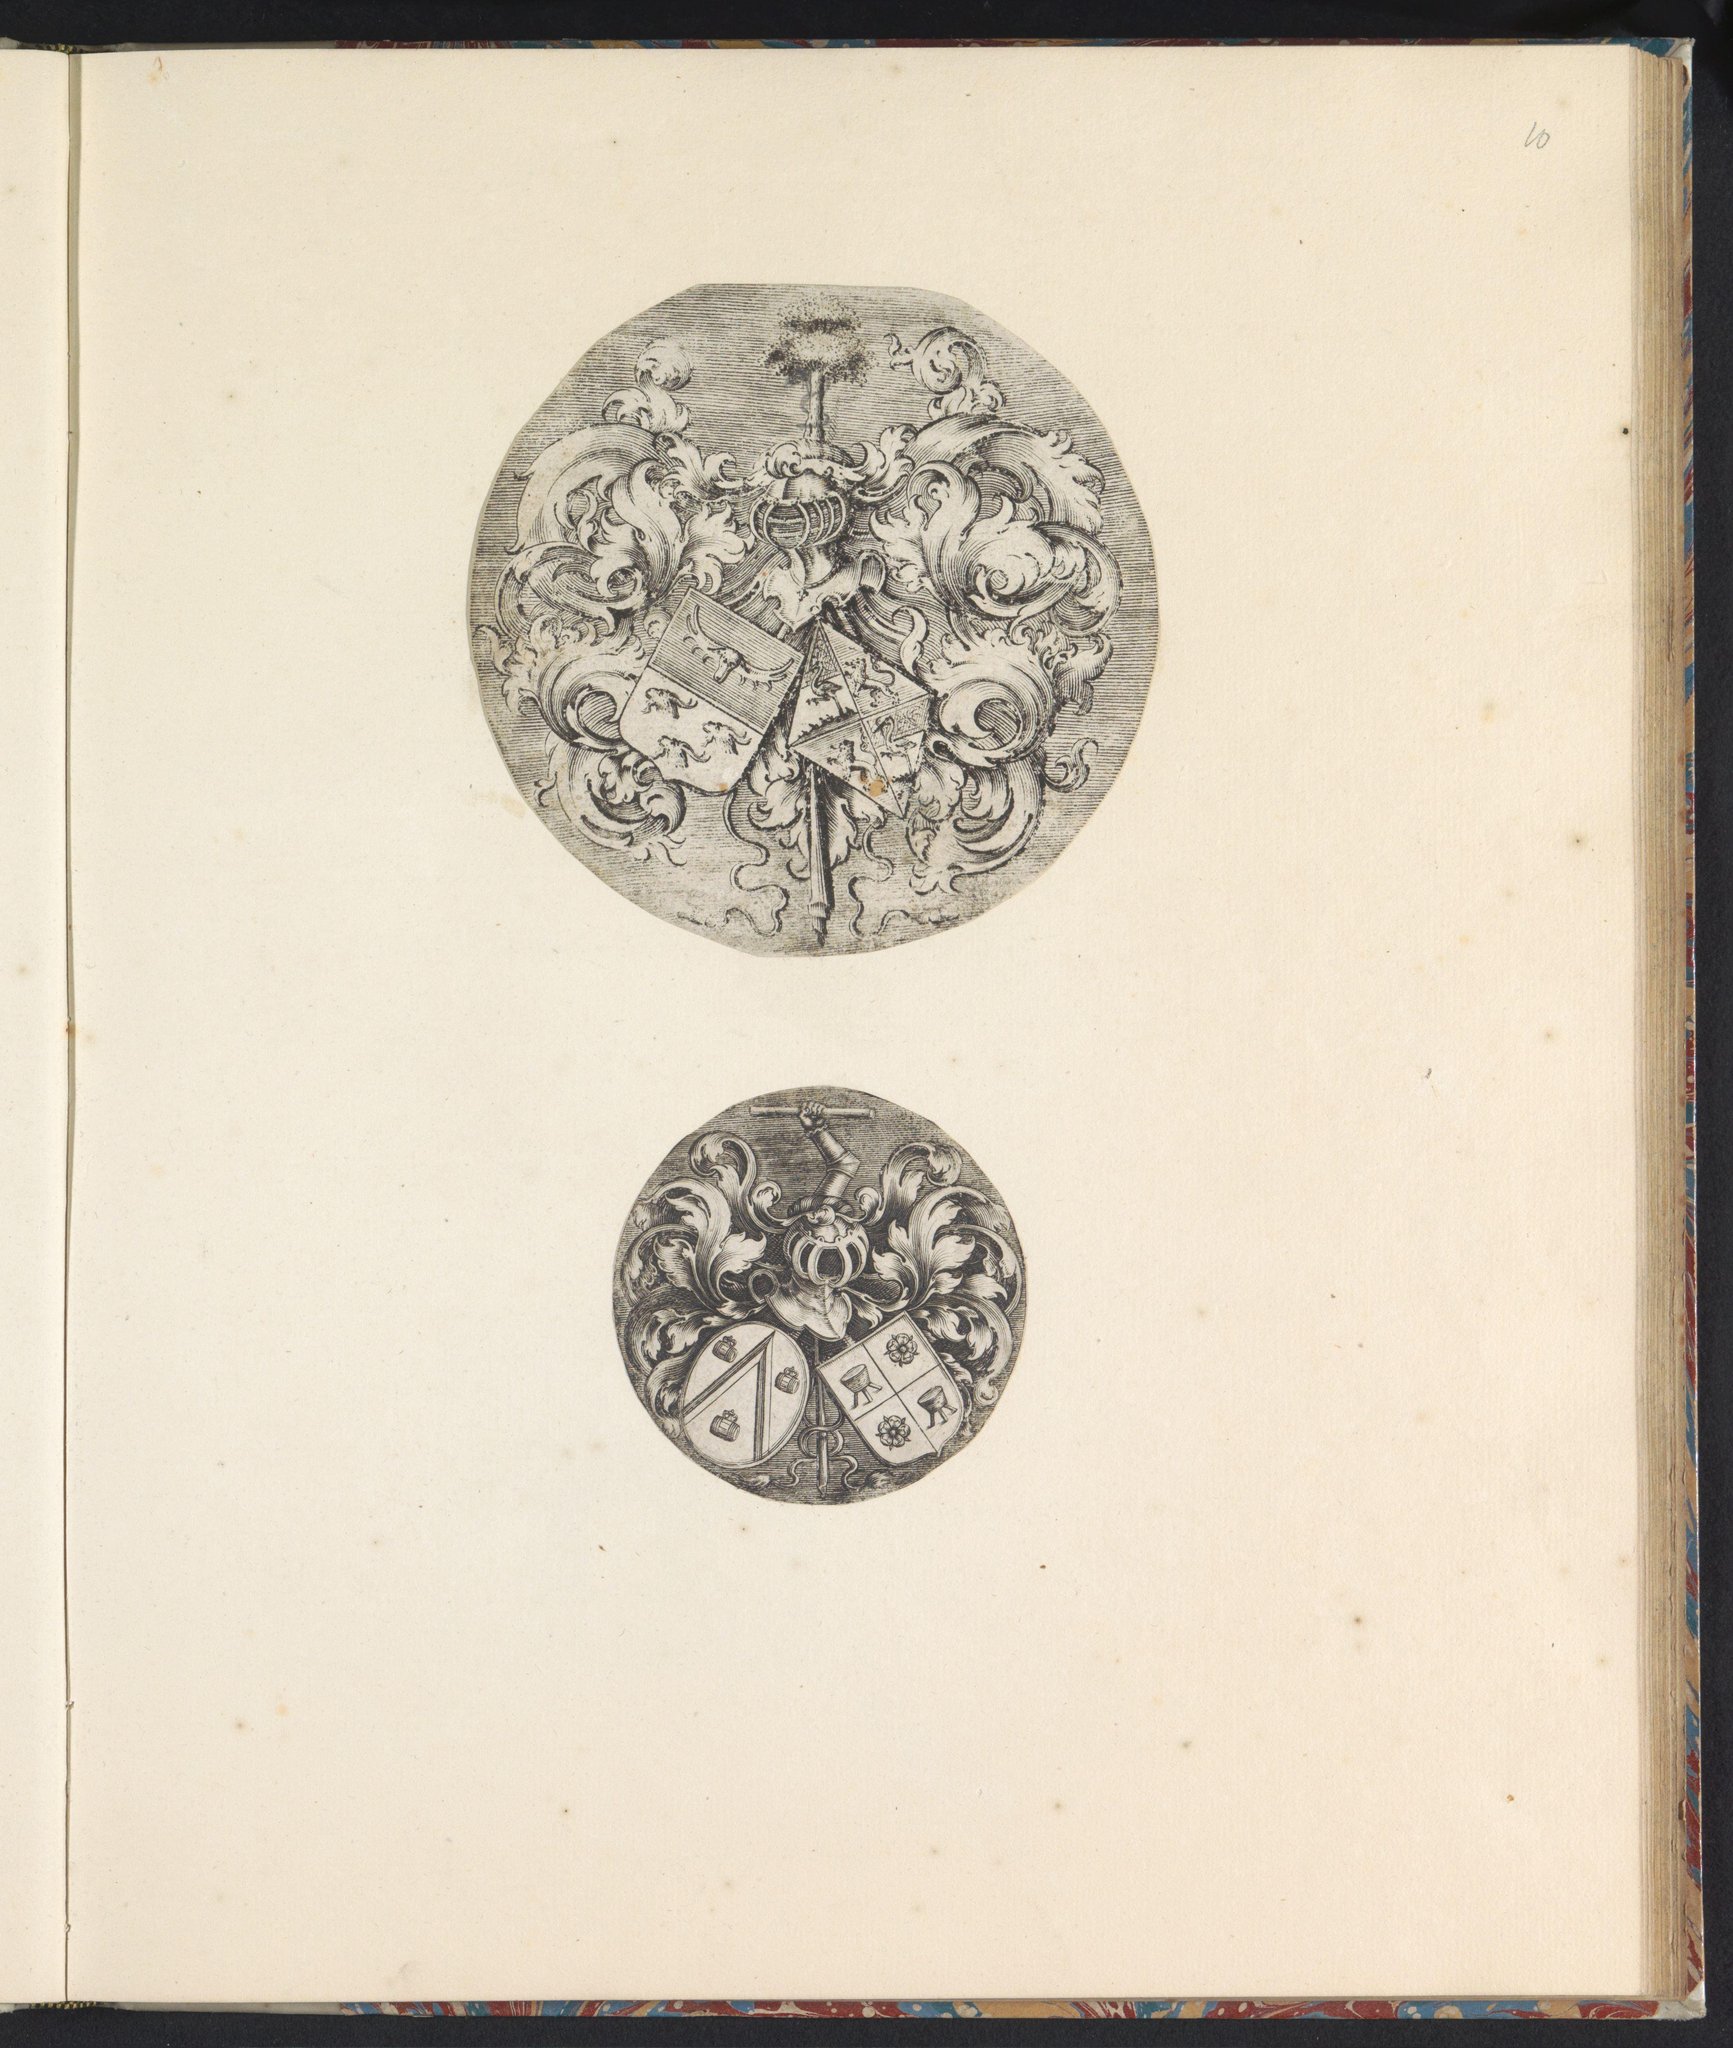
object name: album leaf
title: Twee wapens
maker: Anonymous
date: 1550-1650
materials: paper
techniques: engraving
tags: armorial bearing, heraldry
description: Twee voorstellingen op een albumblad. Het betreffen twee pronkhelmen met wapens. Boven een dubbel schild met links drie geitenkoppen en een gewei en rechts een wapen met twee leeuwen en twee ooievaar (mogelijk familie De Vogelaer). Onderaan een dubbel schild. Het schild links is gerelateerd aan de familie Verlaen of Van der Laen (keper met drie tonnen). Rechts een gevierendeeld schild met twee krukken en twee rozen. De prenten maken deel uit van een album.